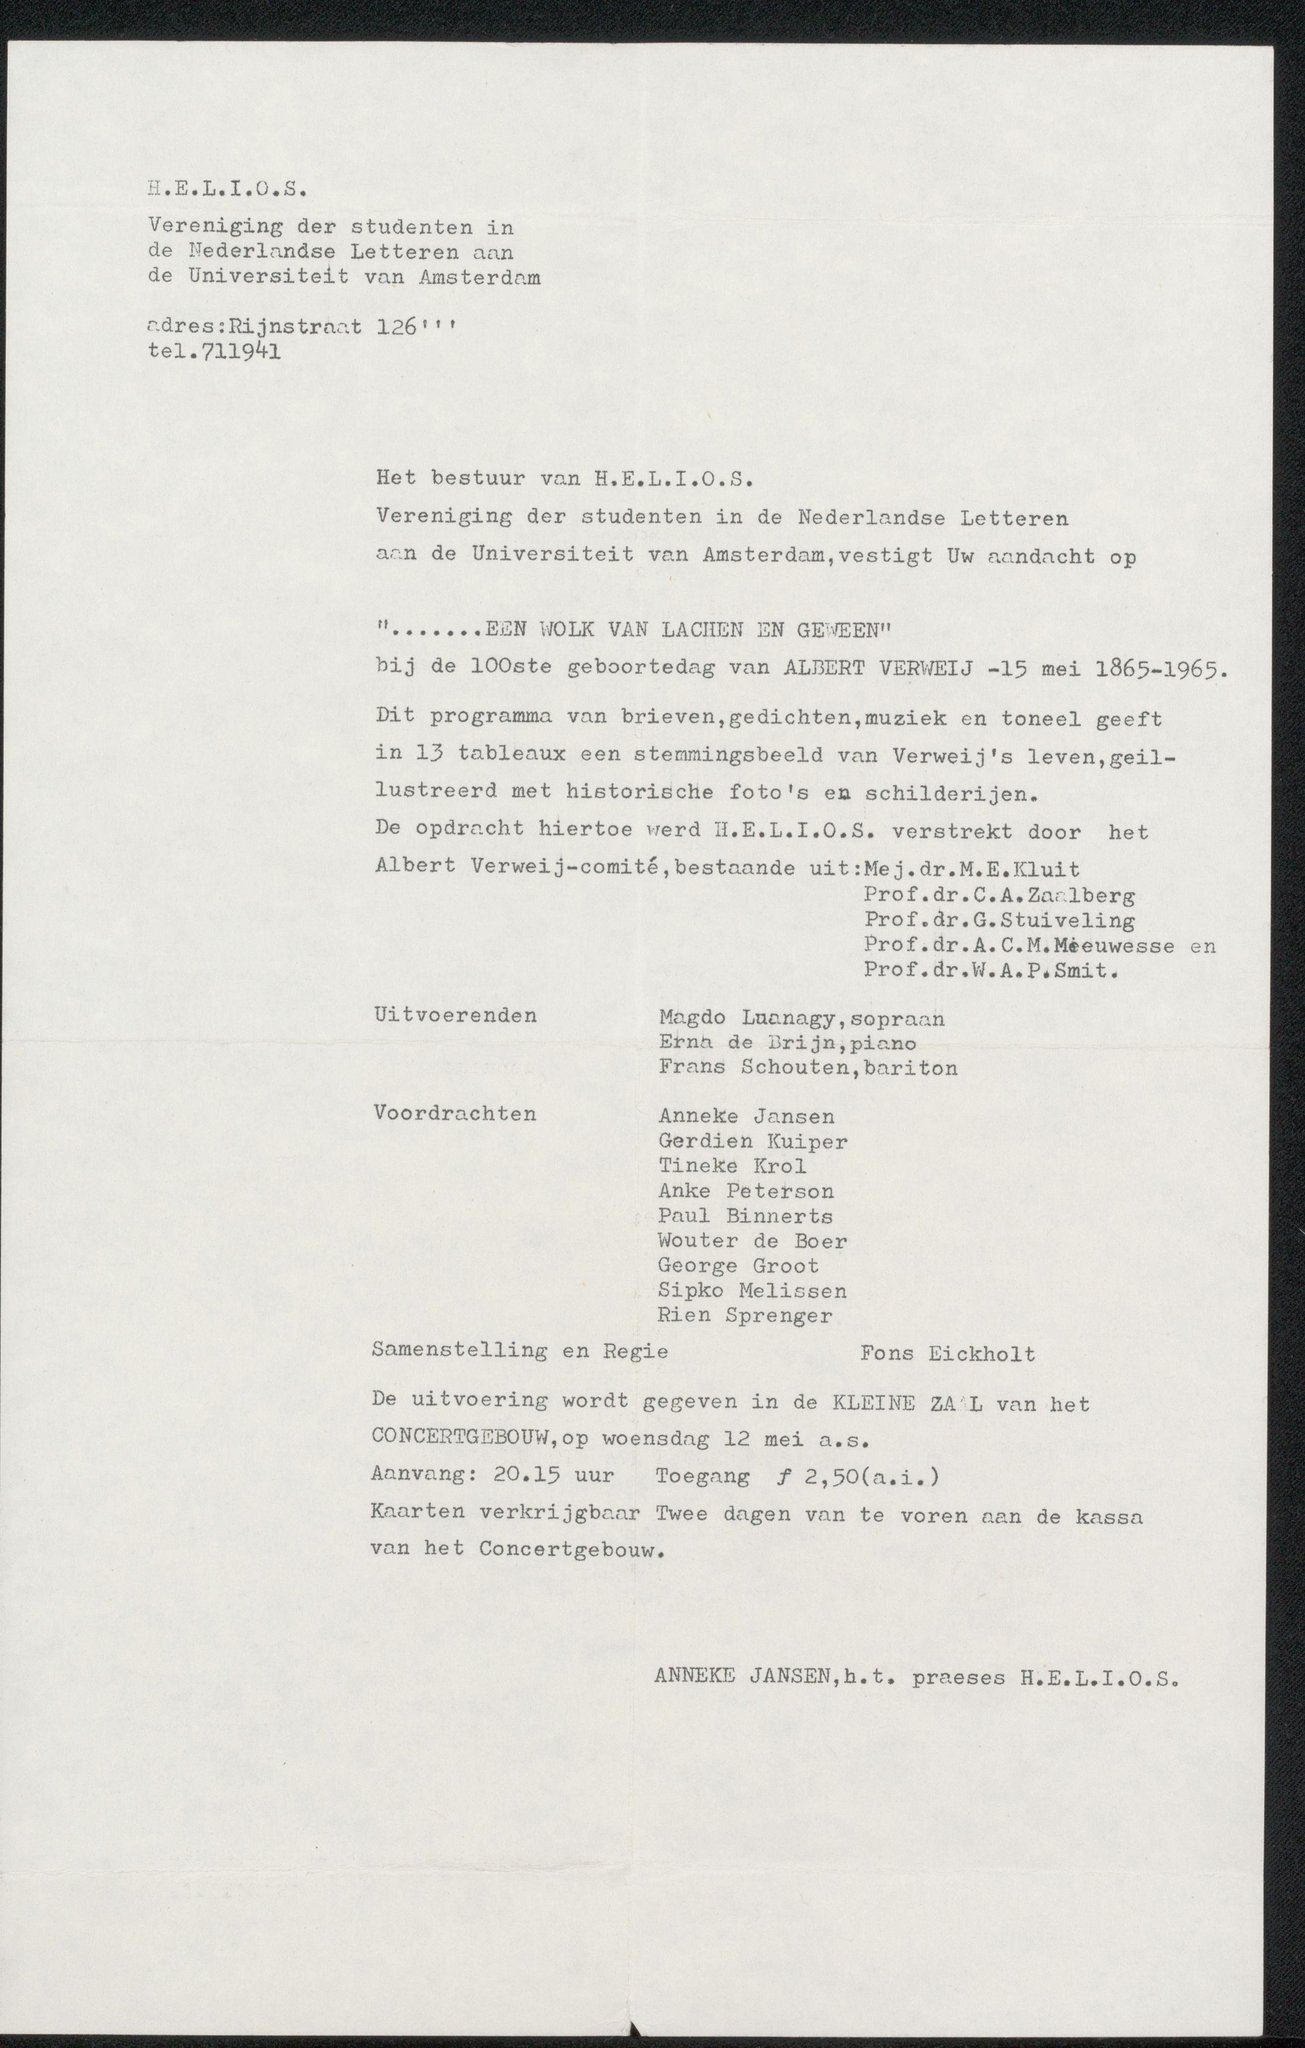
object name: programma, programmaboekje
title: Programma uit archief Jan Veth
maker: Anonymous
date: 1965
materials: paper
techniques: printing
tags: albert verwey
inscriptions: collector's mark: ‘RPK’